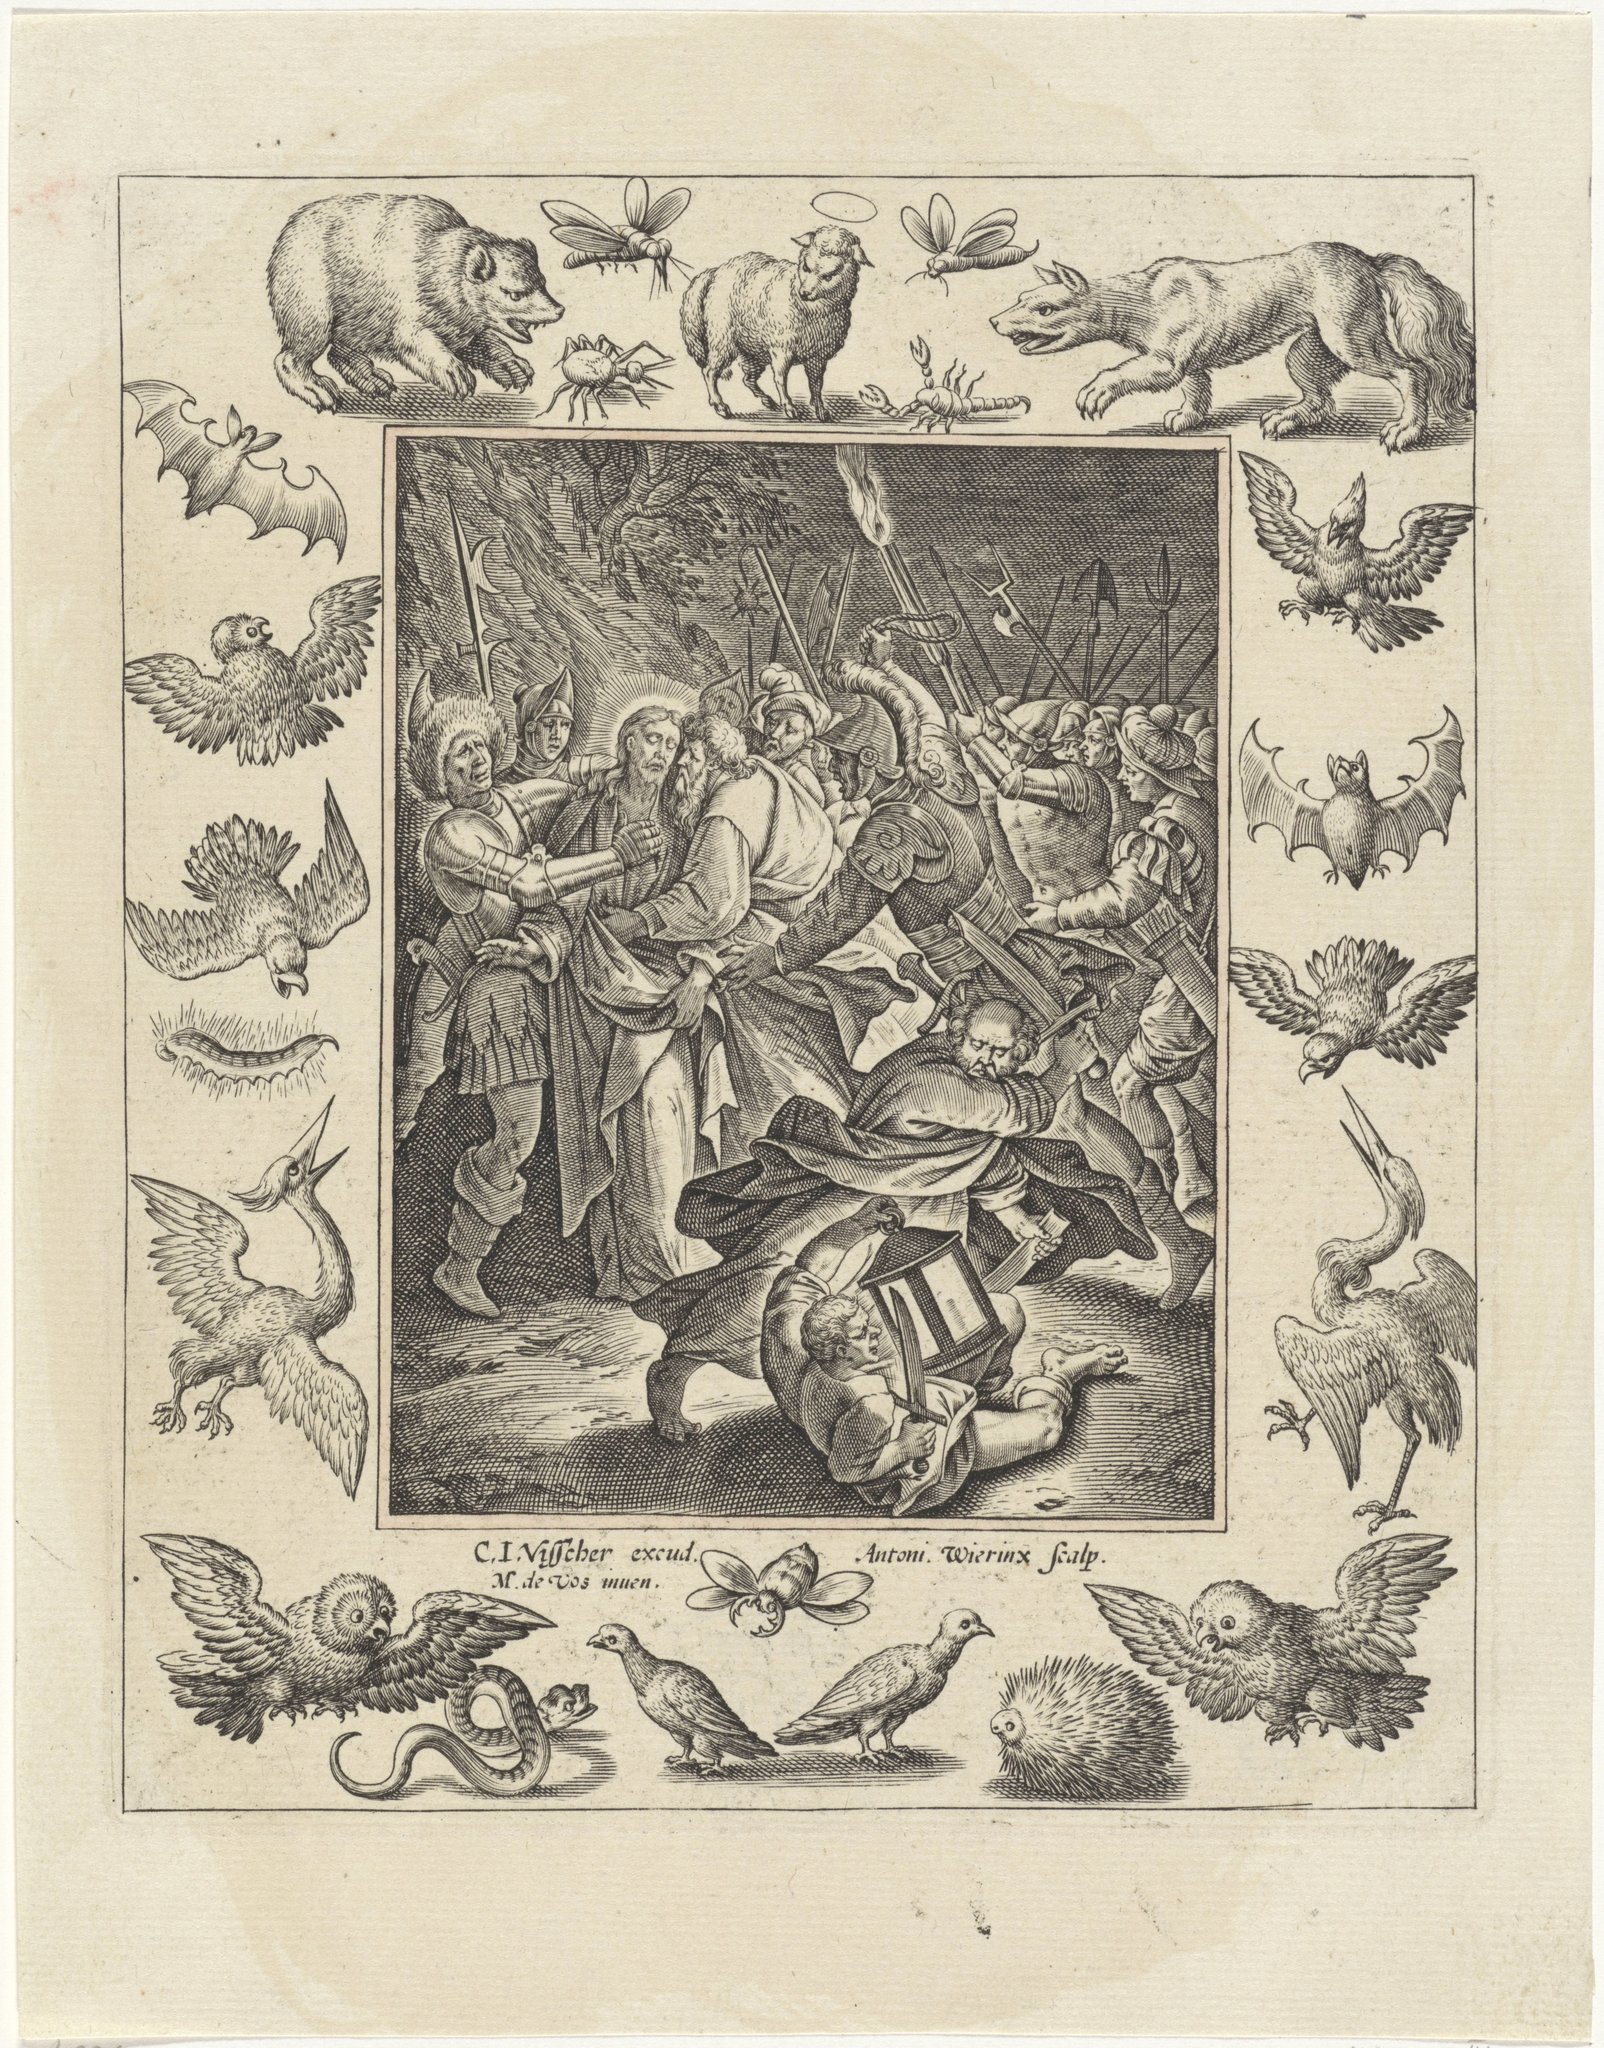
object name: print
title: Judaskus en arrestatie van Christus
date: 1582-1586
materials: paper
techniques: engraving, hand coloring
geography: amsterdam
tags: peter draws his sword and cuts off malchus' ear, the kiss of judas: accompanied by soldiers with torches and lanterns, he kisses christ, animals, symbols of christ ~ animals, insects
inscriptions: collector's mark: Lugt 2228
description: Judas kust Christus op de wang. De soldaten omsingelen en arresteren hem. Petrus staat op het punt het oor van Malchus af te hakken. De voorstelling is gevat in een omlijsting die is gedecoreerd met verschillende dieren en insecten en het heilig Lam.